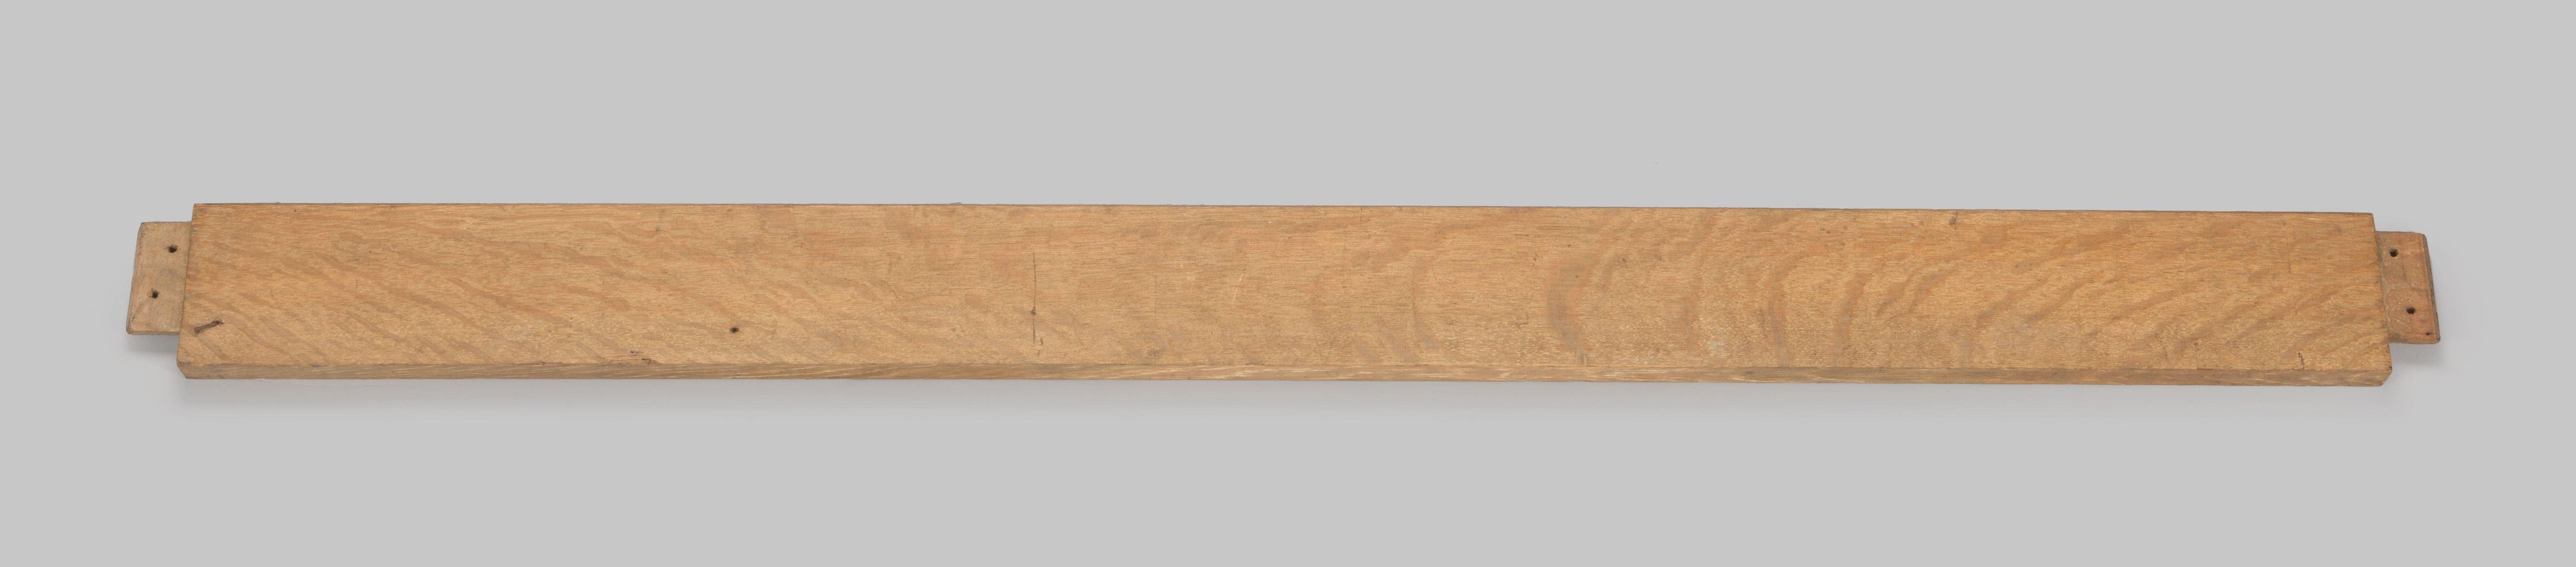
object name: bed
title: Four-poster bed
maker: Anonymous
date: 1715-1720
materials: wood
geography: netherlands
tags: ornament derived from plant forms